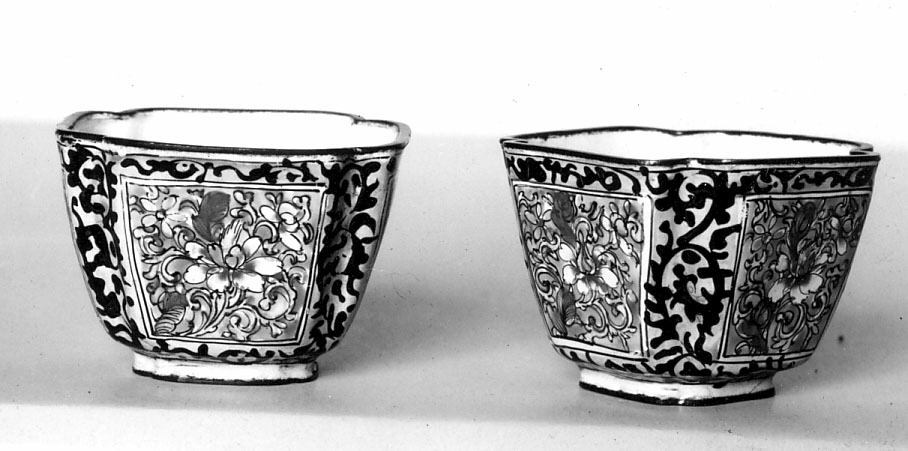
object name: cup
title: Square Cup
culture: chinese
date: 1801-1900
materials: enamel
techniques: painting